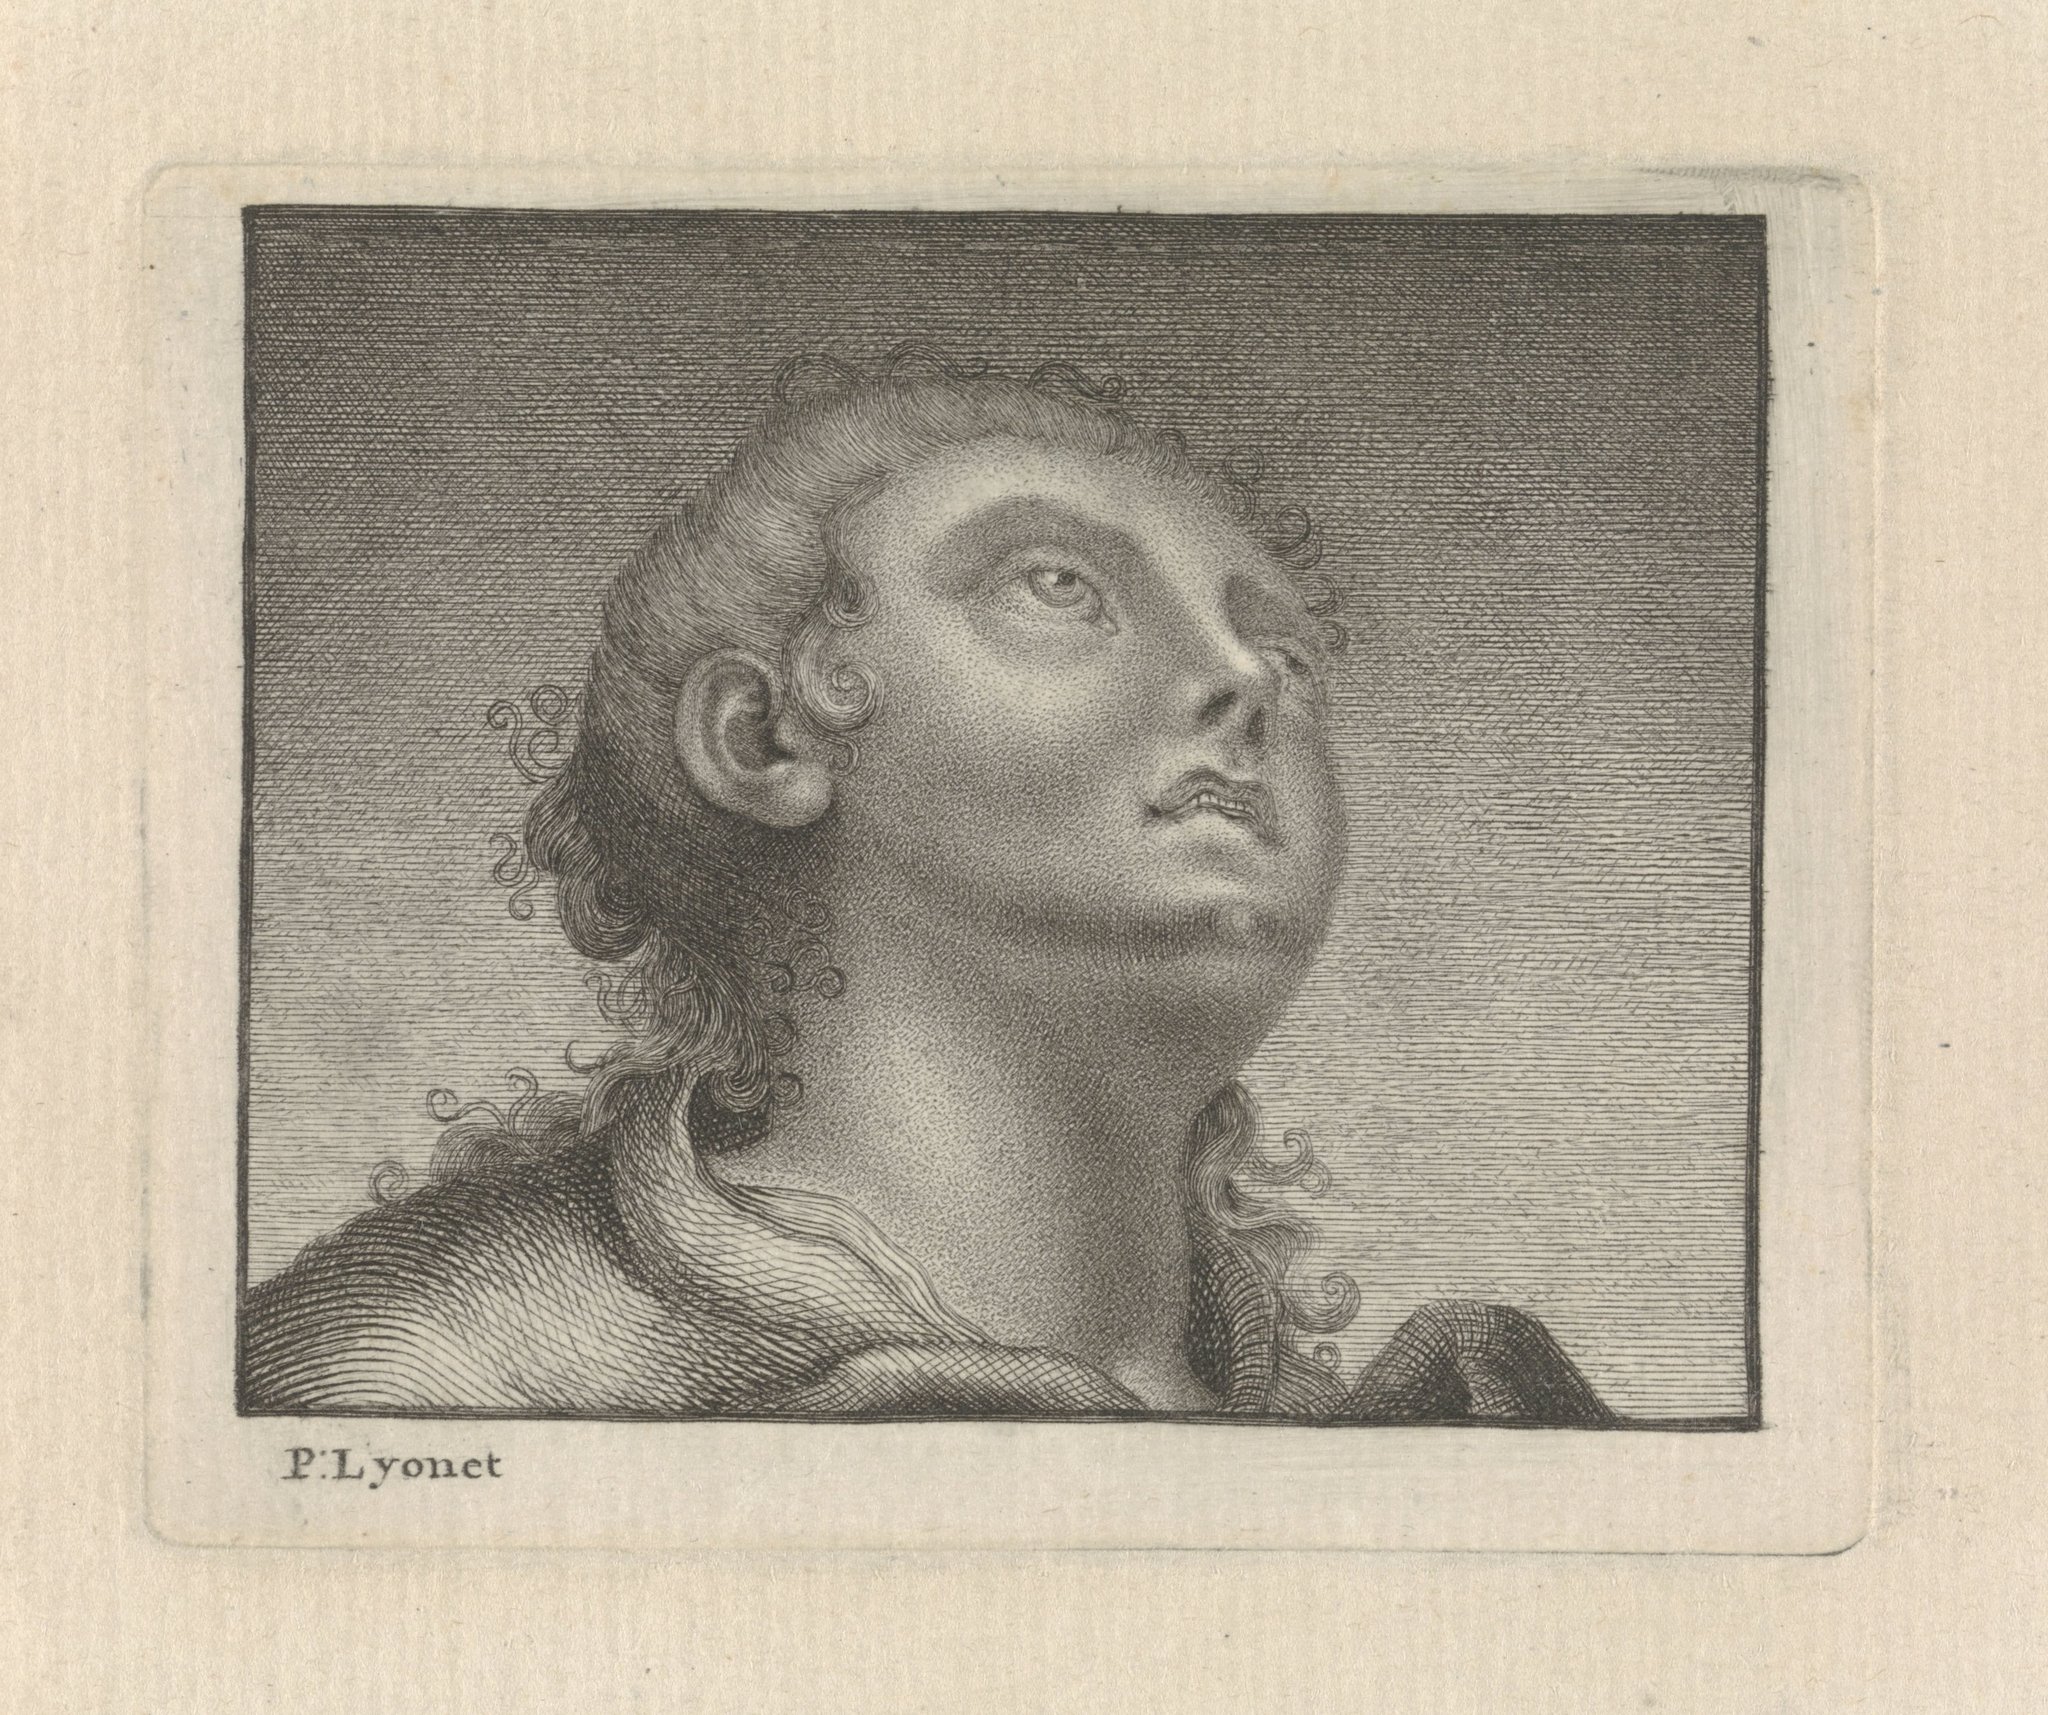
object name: print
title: Opkijkende jongeman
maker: pieter lyonet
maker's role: draughtsman, print maker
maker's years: 1706-1789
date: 1716-1789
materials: paper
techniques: engraving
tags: youth, adolescent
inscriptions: collector's mark: Lugt 2228